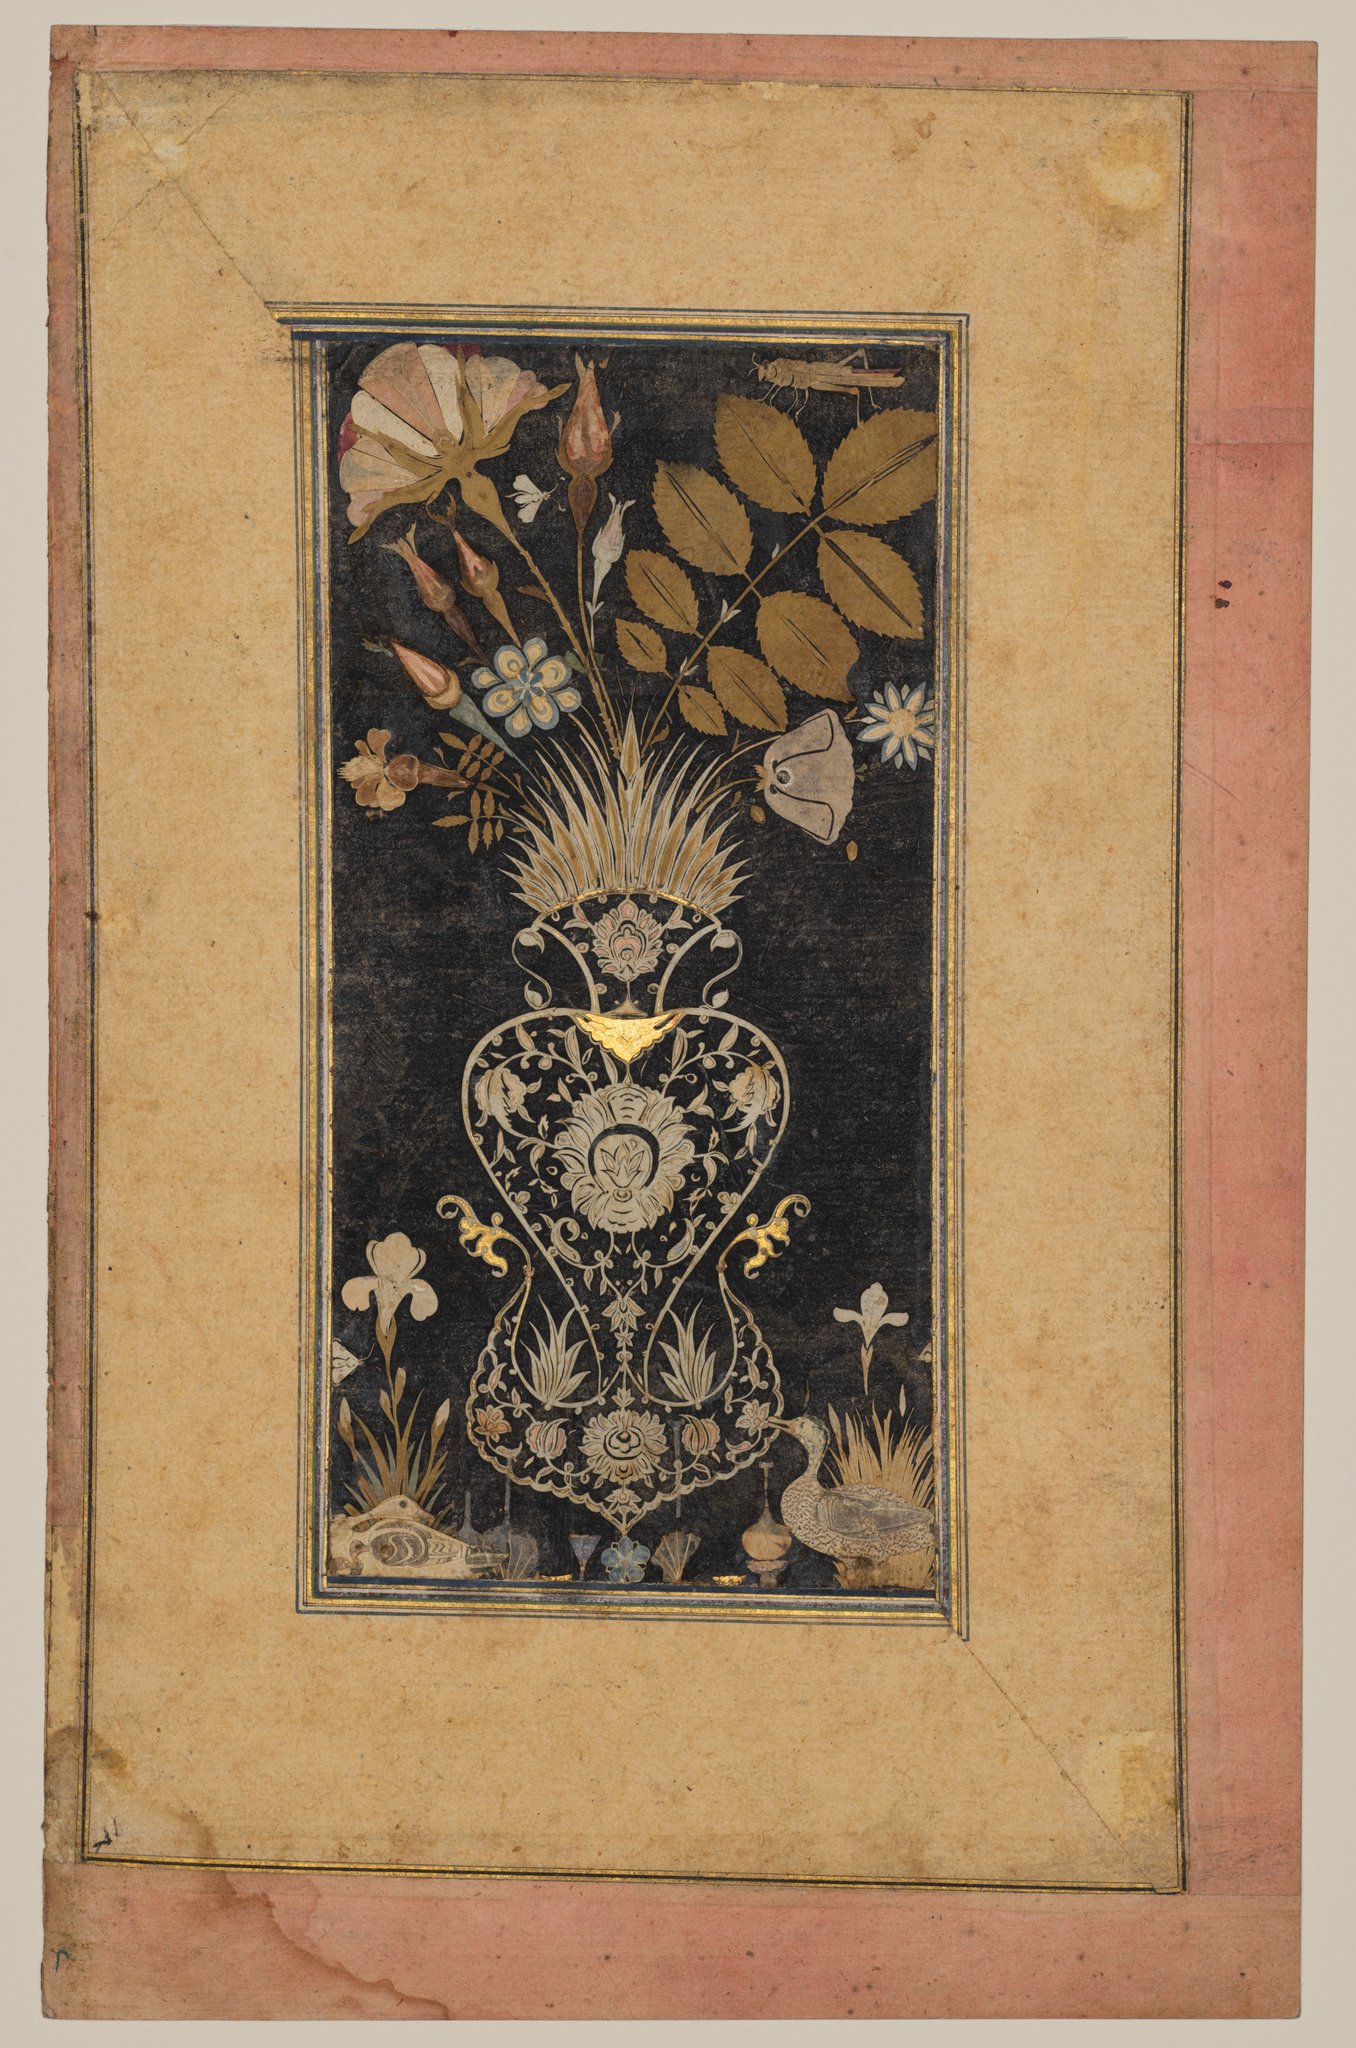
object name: illustrated album leaf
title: Album Page with Decoupe Vase of Flowers, Insects, and Birds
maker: muhammad hasan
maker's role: artist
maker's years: 1605-1665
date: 1630-1640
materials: gouache, paper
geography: india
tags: birds,insects,flowers